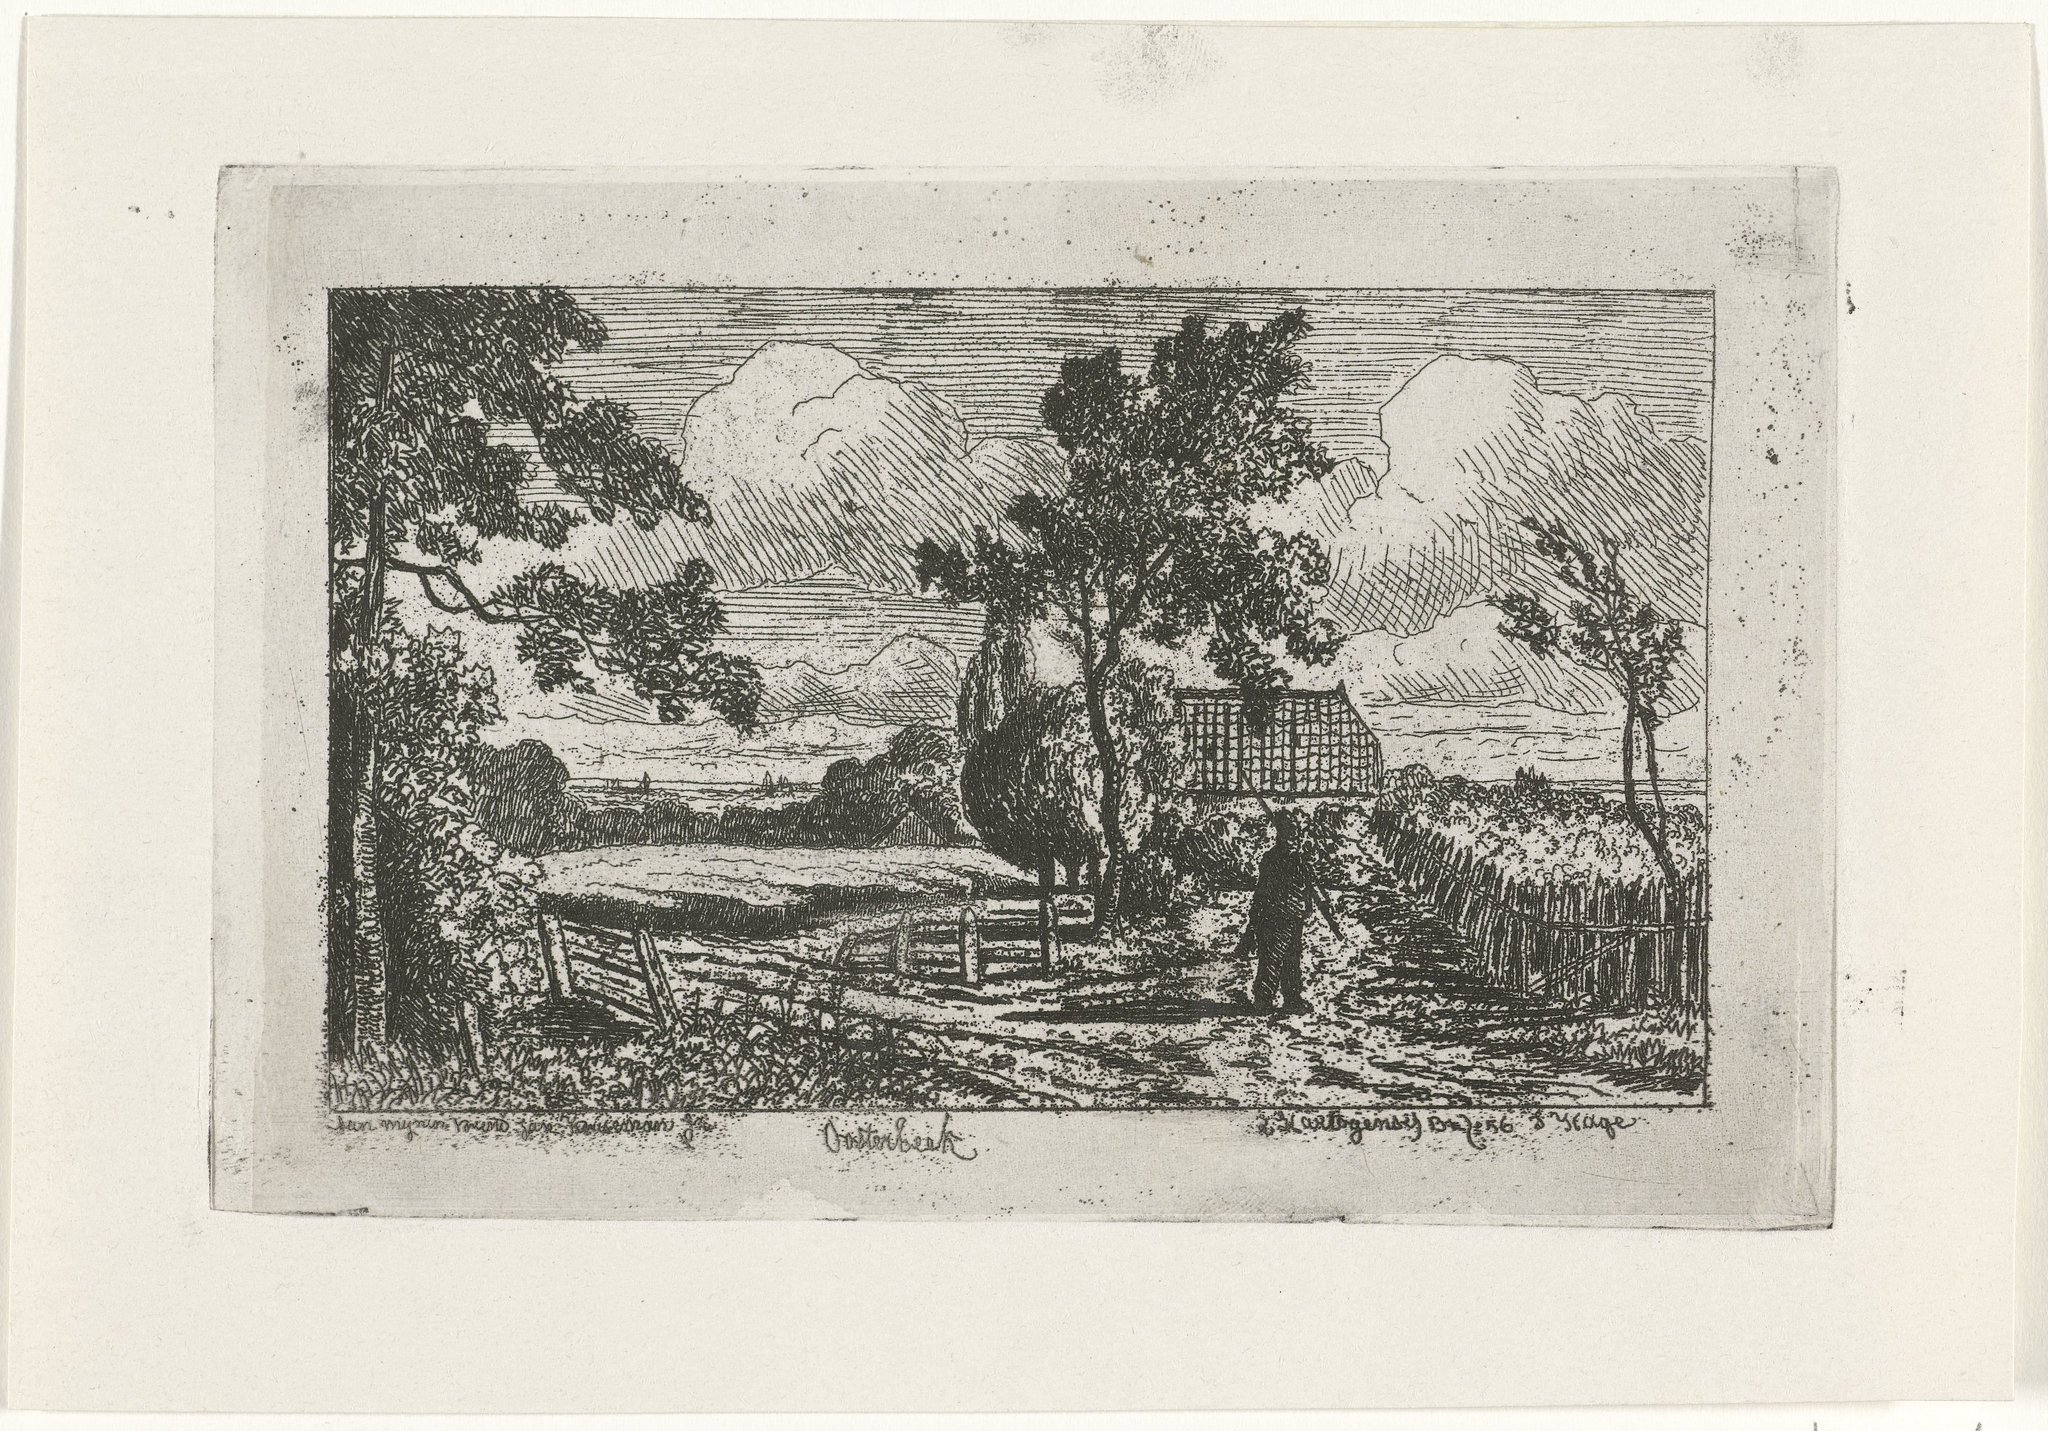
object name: print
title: Oosterbeek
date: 1856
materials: paper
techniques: etching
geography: the hague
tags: farm or solitary house in landscape (+ city(-scape) with figures, staffage)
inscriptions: collector's mark: Lugt 2228